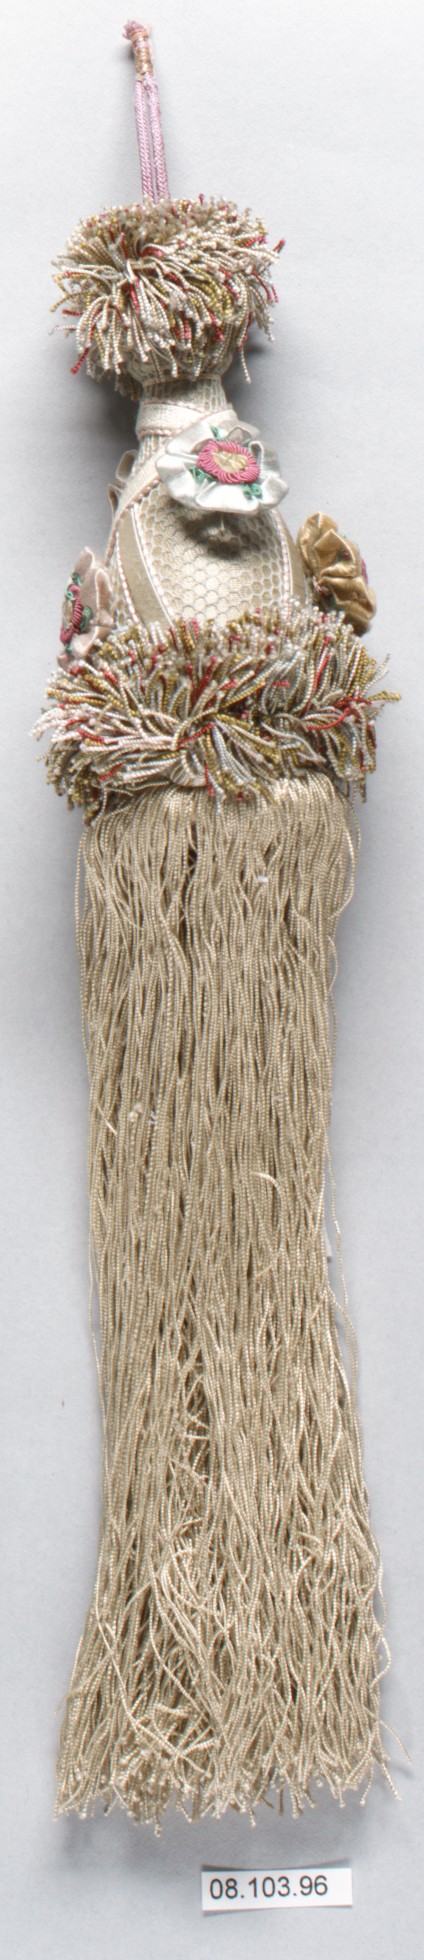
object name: tassel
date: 1701-1800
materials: silk